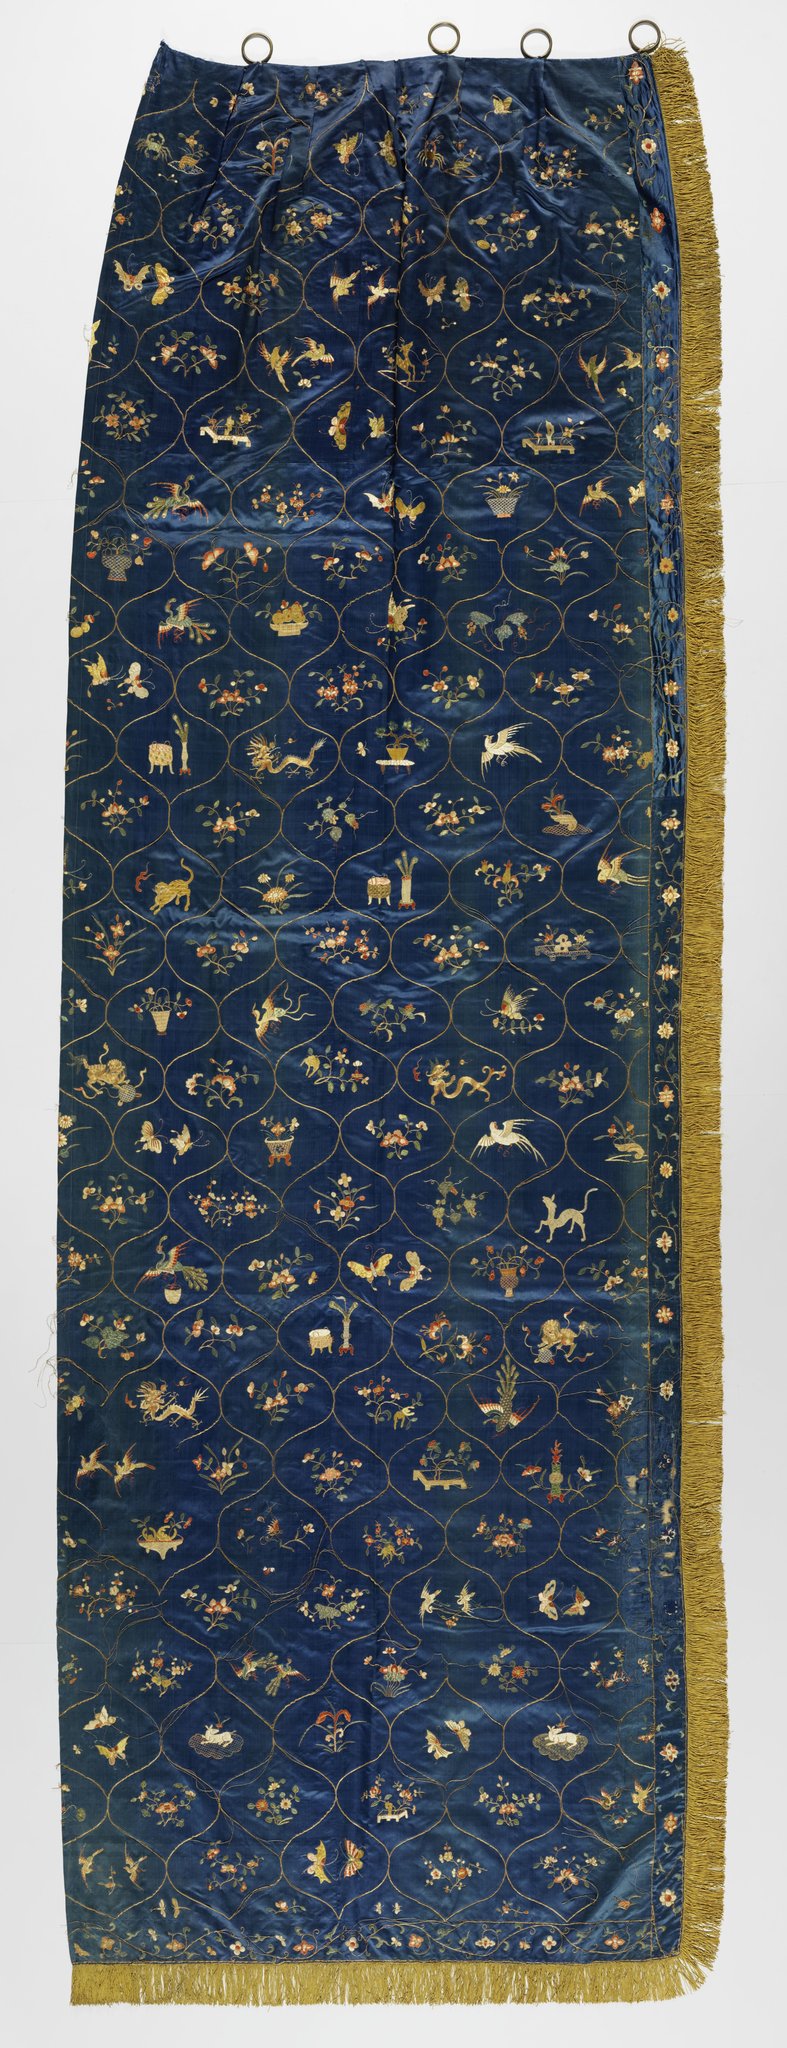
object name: curtain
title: Gordijn van blauw zijde met borduurwerk in Chinese trant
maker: Anonymous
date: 1880-1900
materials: brass, metal thread, silk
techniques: satin binding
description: Gordijn van blauw zijde met borduursel in zijde en goudkleurig metaaldraad in Chinese trant. Mogelijk in China geborduurd. Donkerblauw fond met florale motieven, dieren en mythische wezens in spitsovalen van metaaldraad. Voorzien van messing ringen aan de bovenzijde, versierd met franjes langs twee zijden. Eén losse ring.